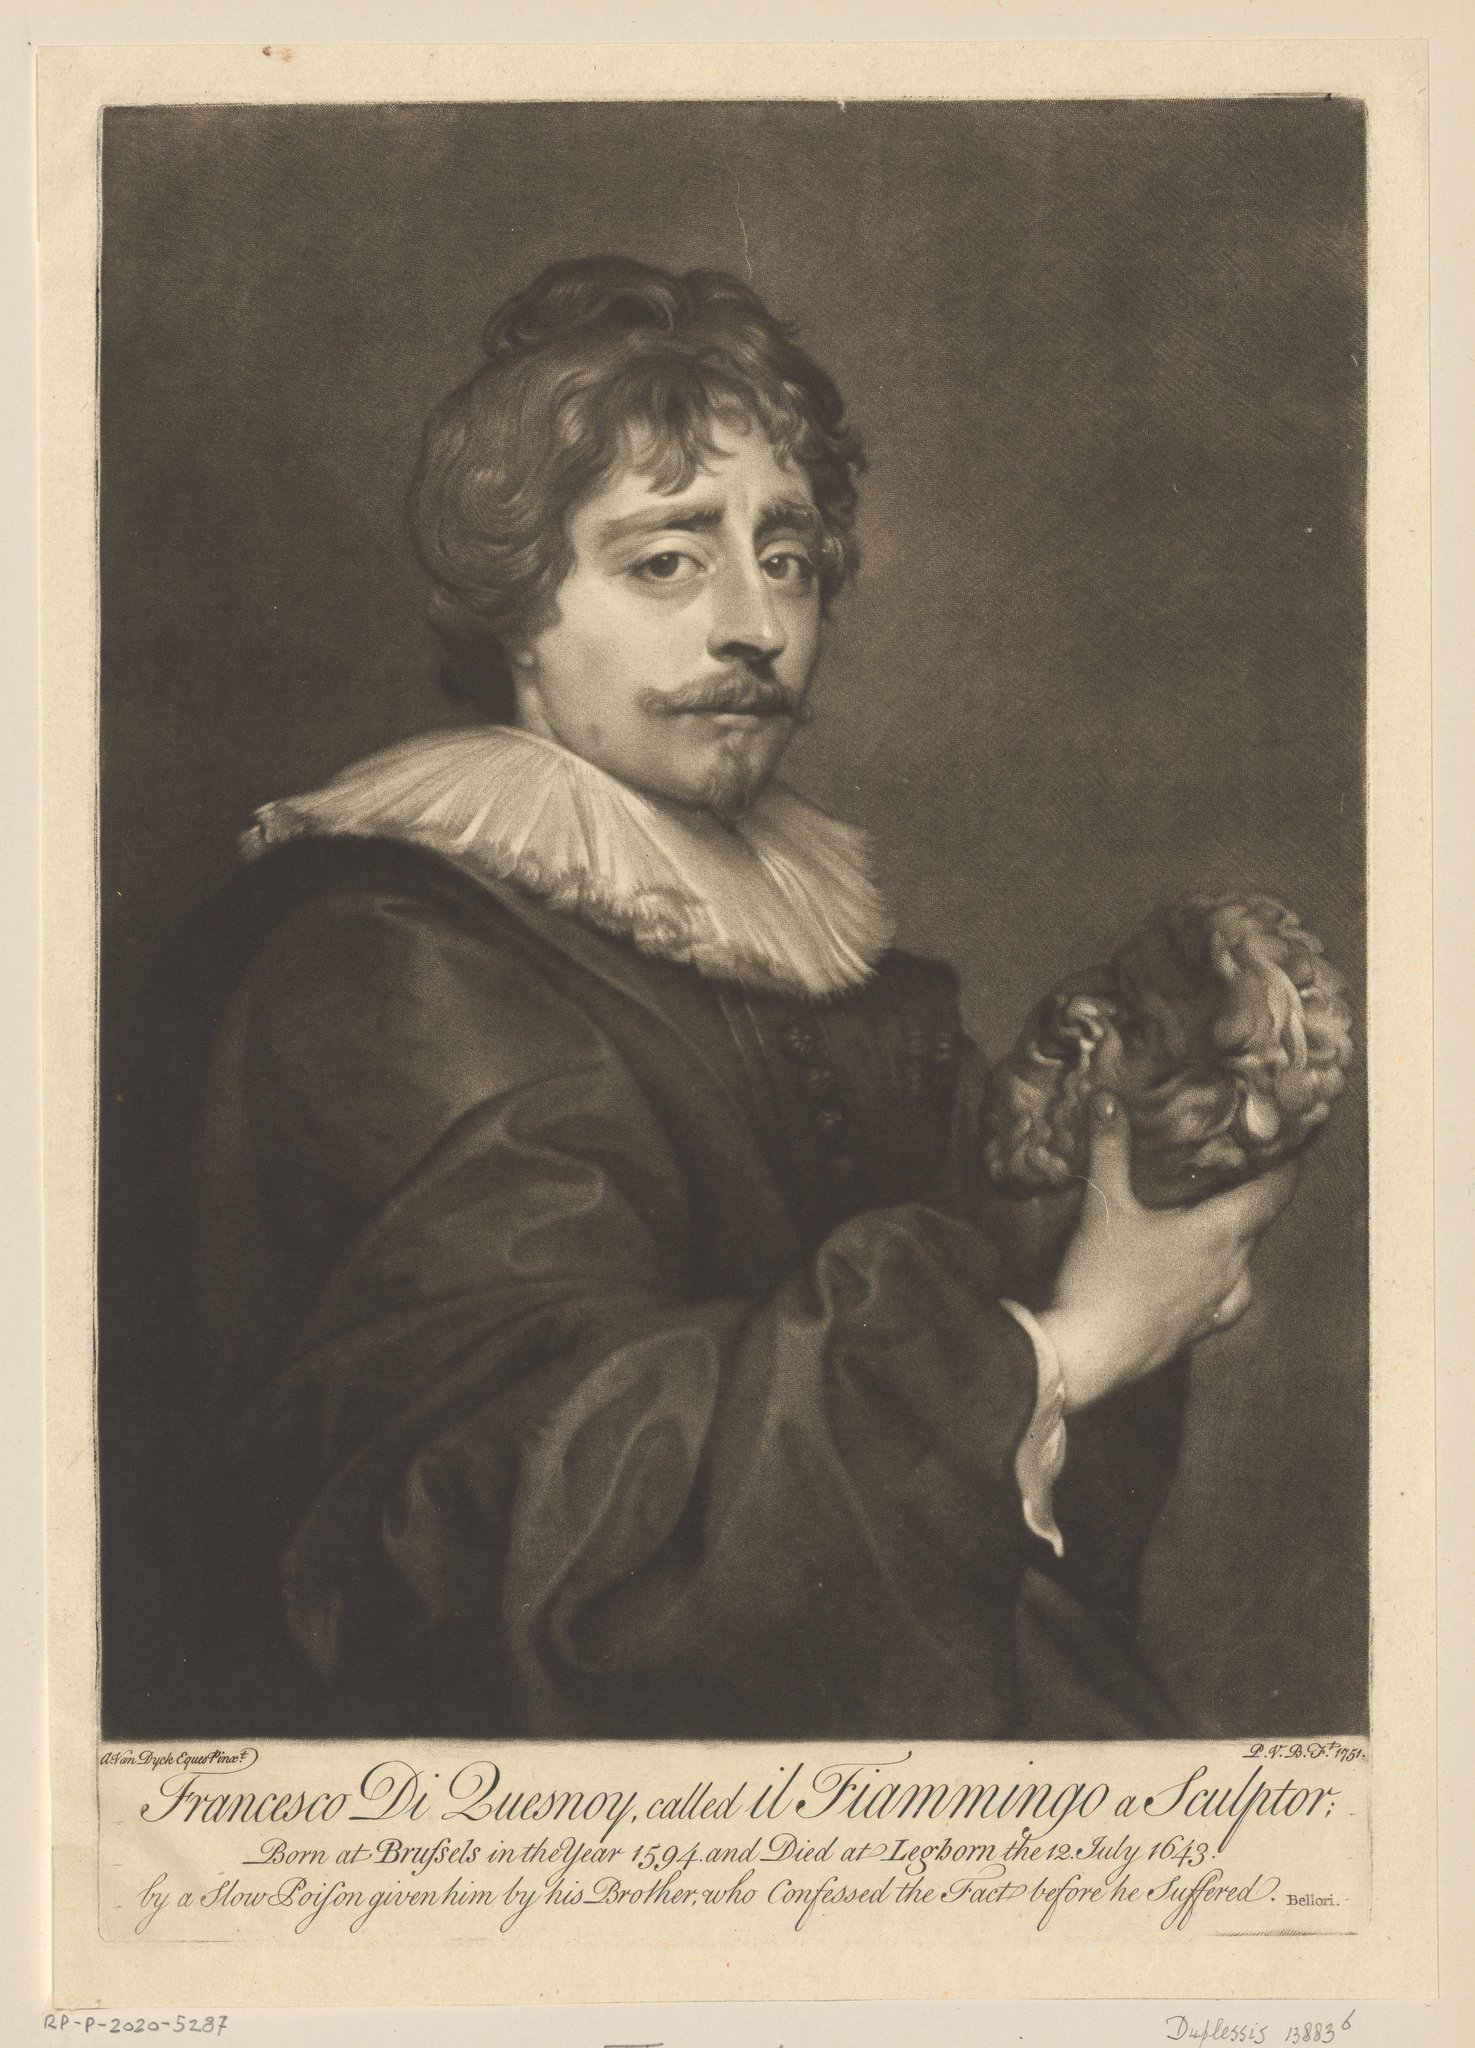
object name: print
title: Portret van François Du Quesnoy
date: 1751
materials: paper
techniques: mezzotint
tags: brussels, draughtsman, sculptor, françois du quesnoy, portrait, self-portrait of sculptor, historical persons, sculpture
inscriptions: collector's mark: Lugt 240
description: Met een gebeeldhouwde kop in zijn handen.